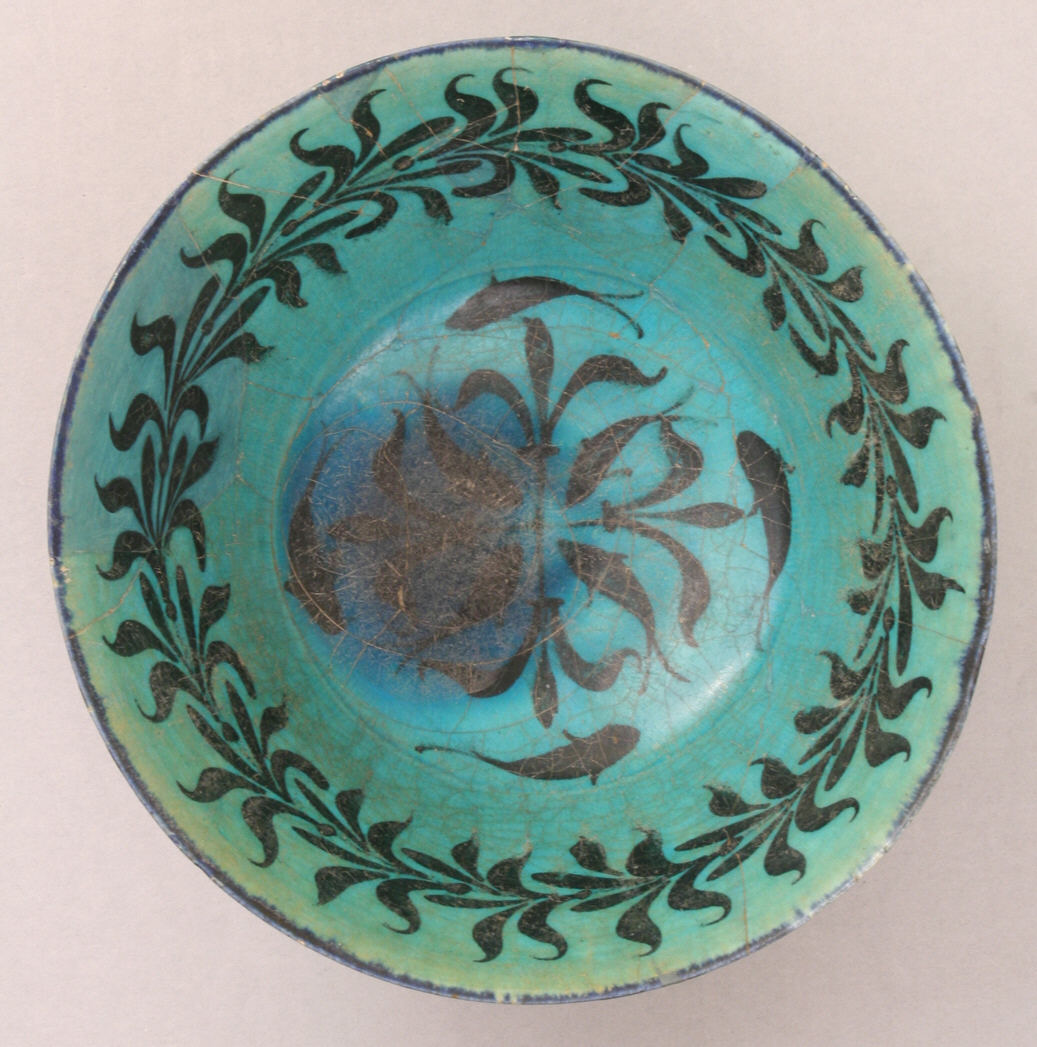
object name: bowl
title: Bowl with Scrolls and Fishes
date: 1201-1300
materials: stonepaste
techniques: painting, underglaze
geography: iran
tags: fish